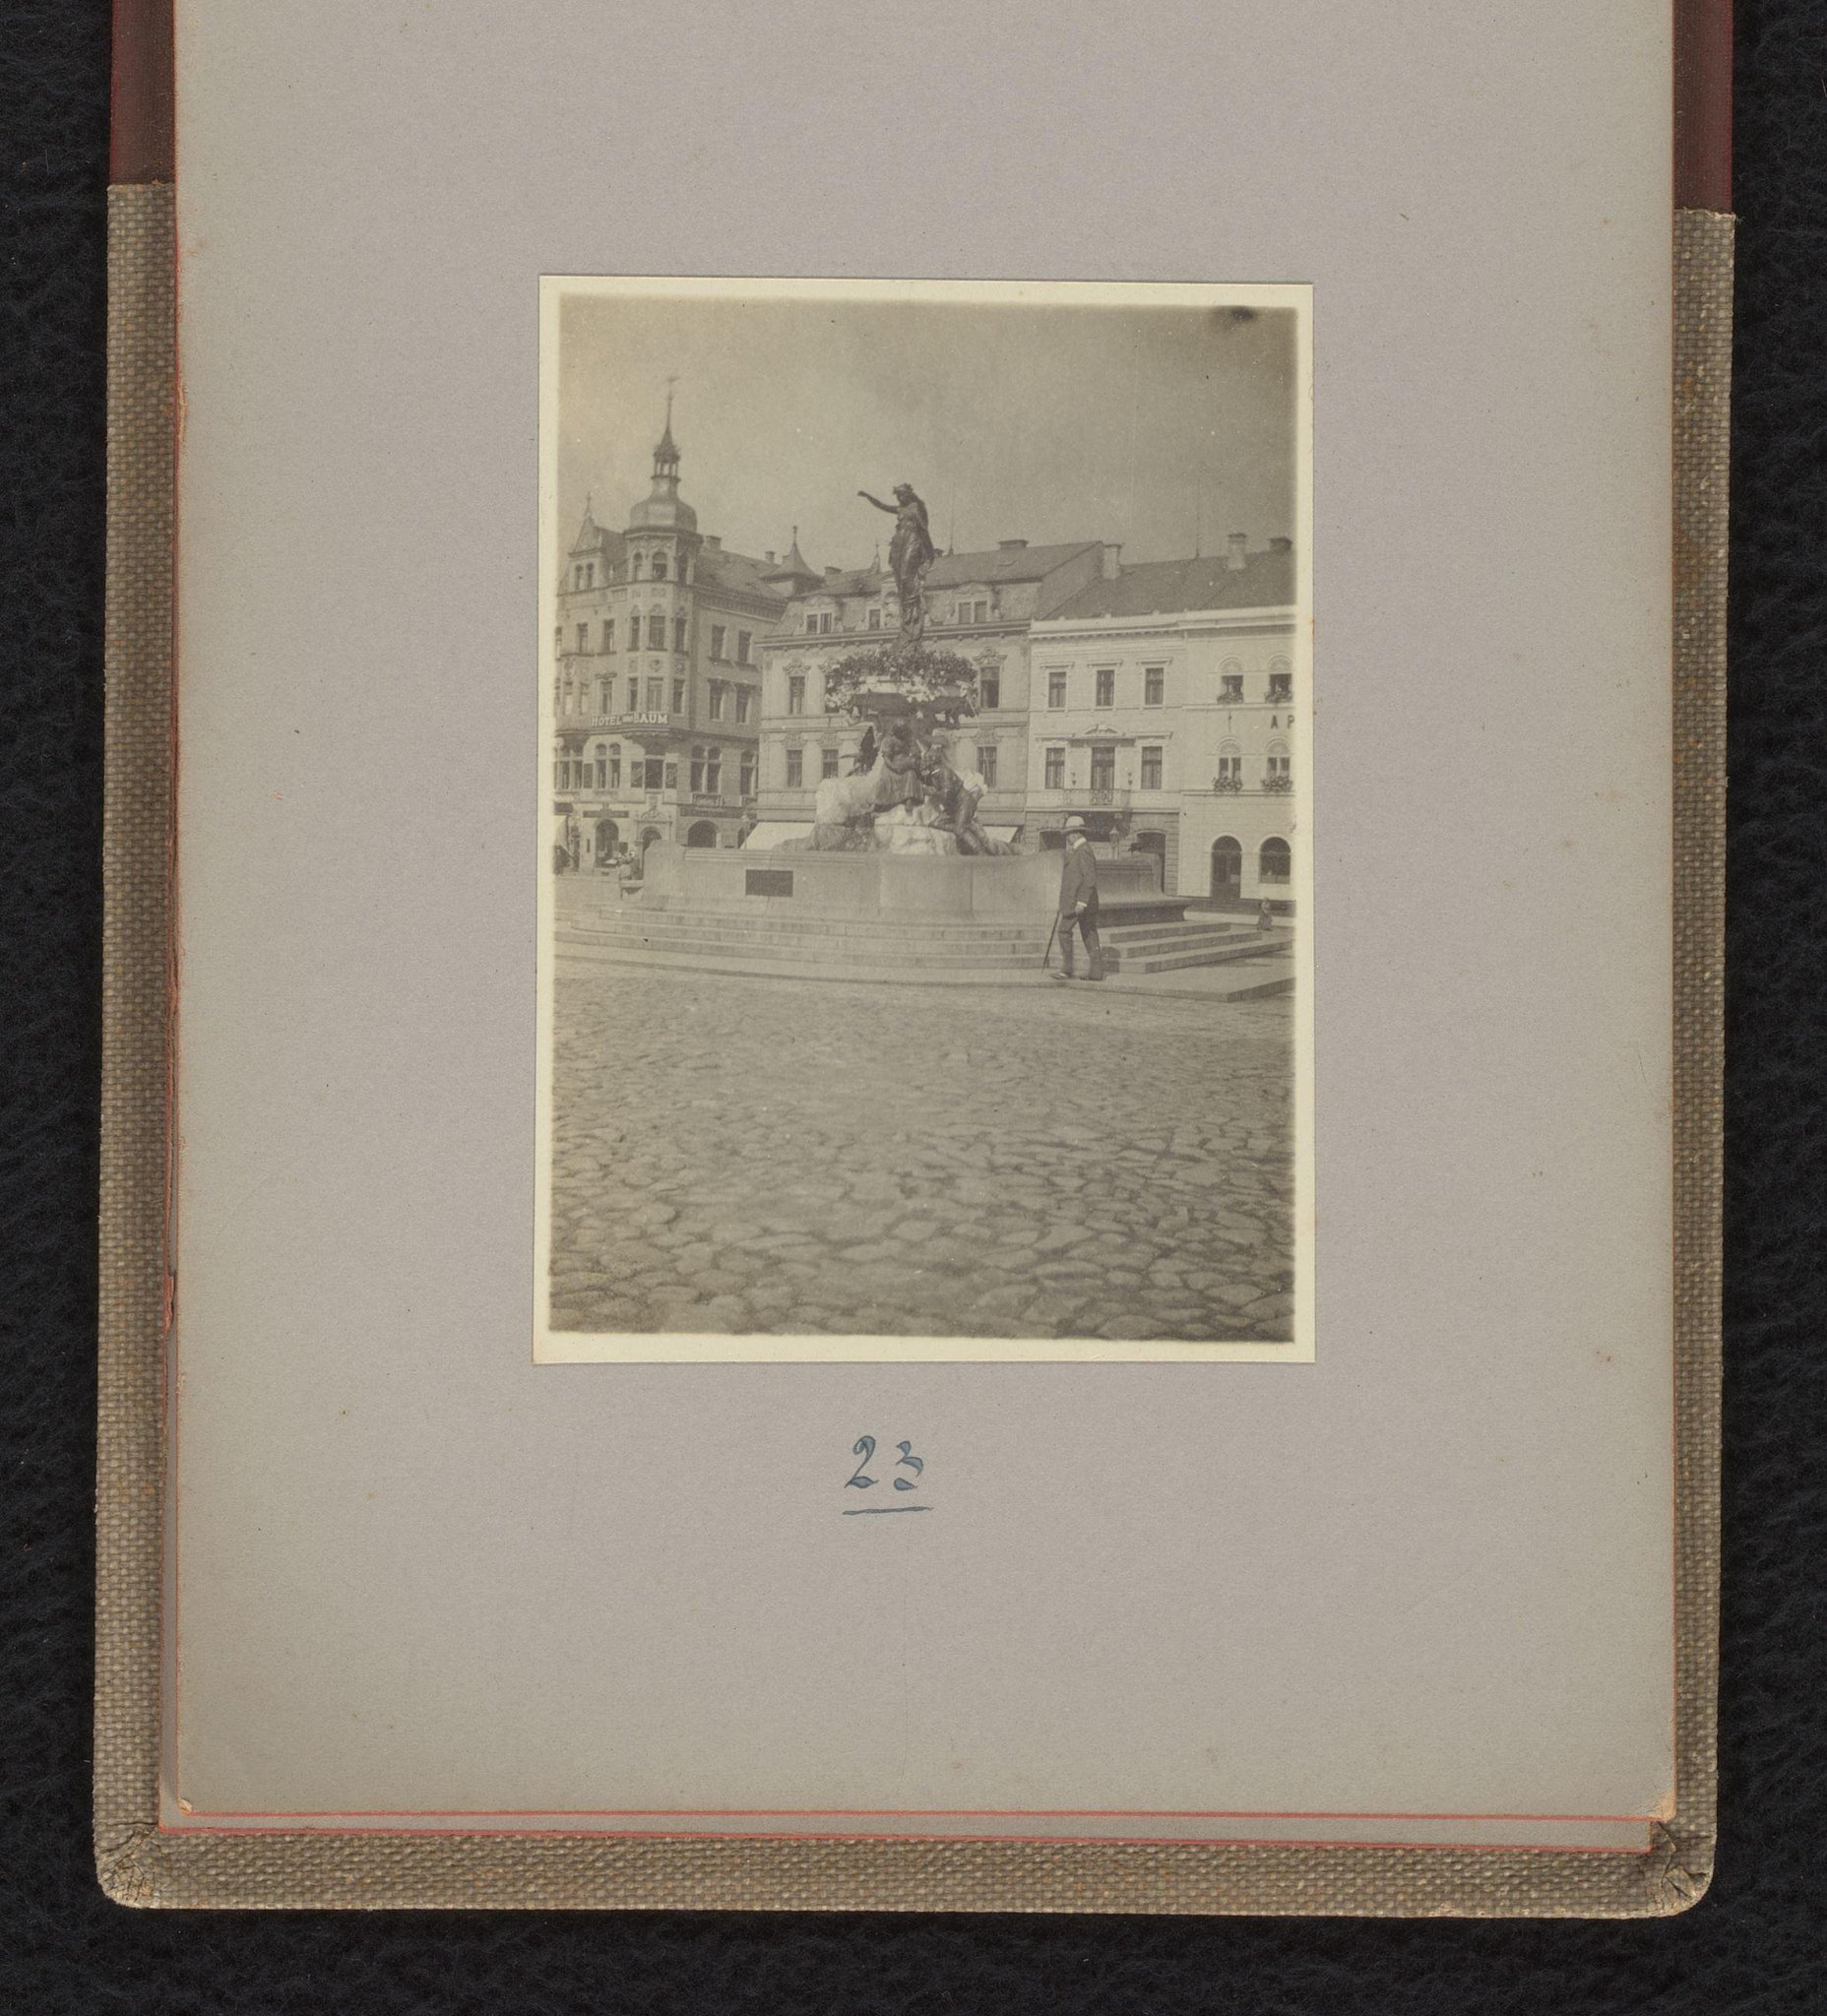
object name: photograph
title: Markt van Tetschen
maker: johan herman kessler (jan)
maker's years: 1892-1978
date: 1910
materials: paper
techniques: gelatin silver print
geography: decín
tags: square, place, circus, etc.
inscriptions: number: ‘23’